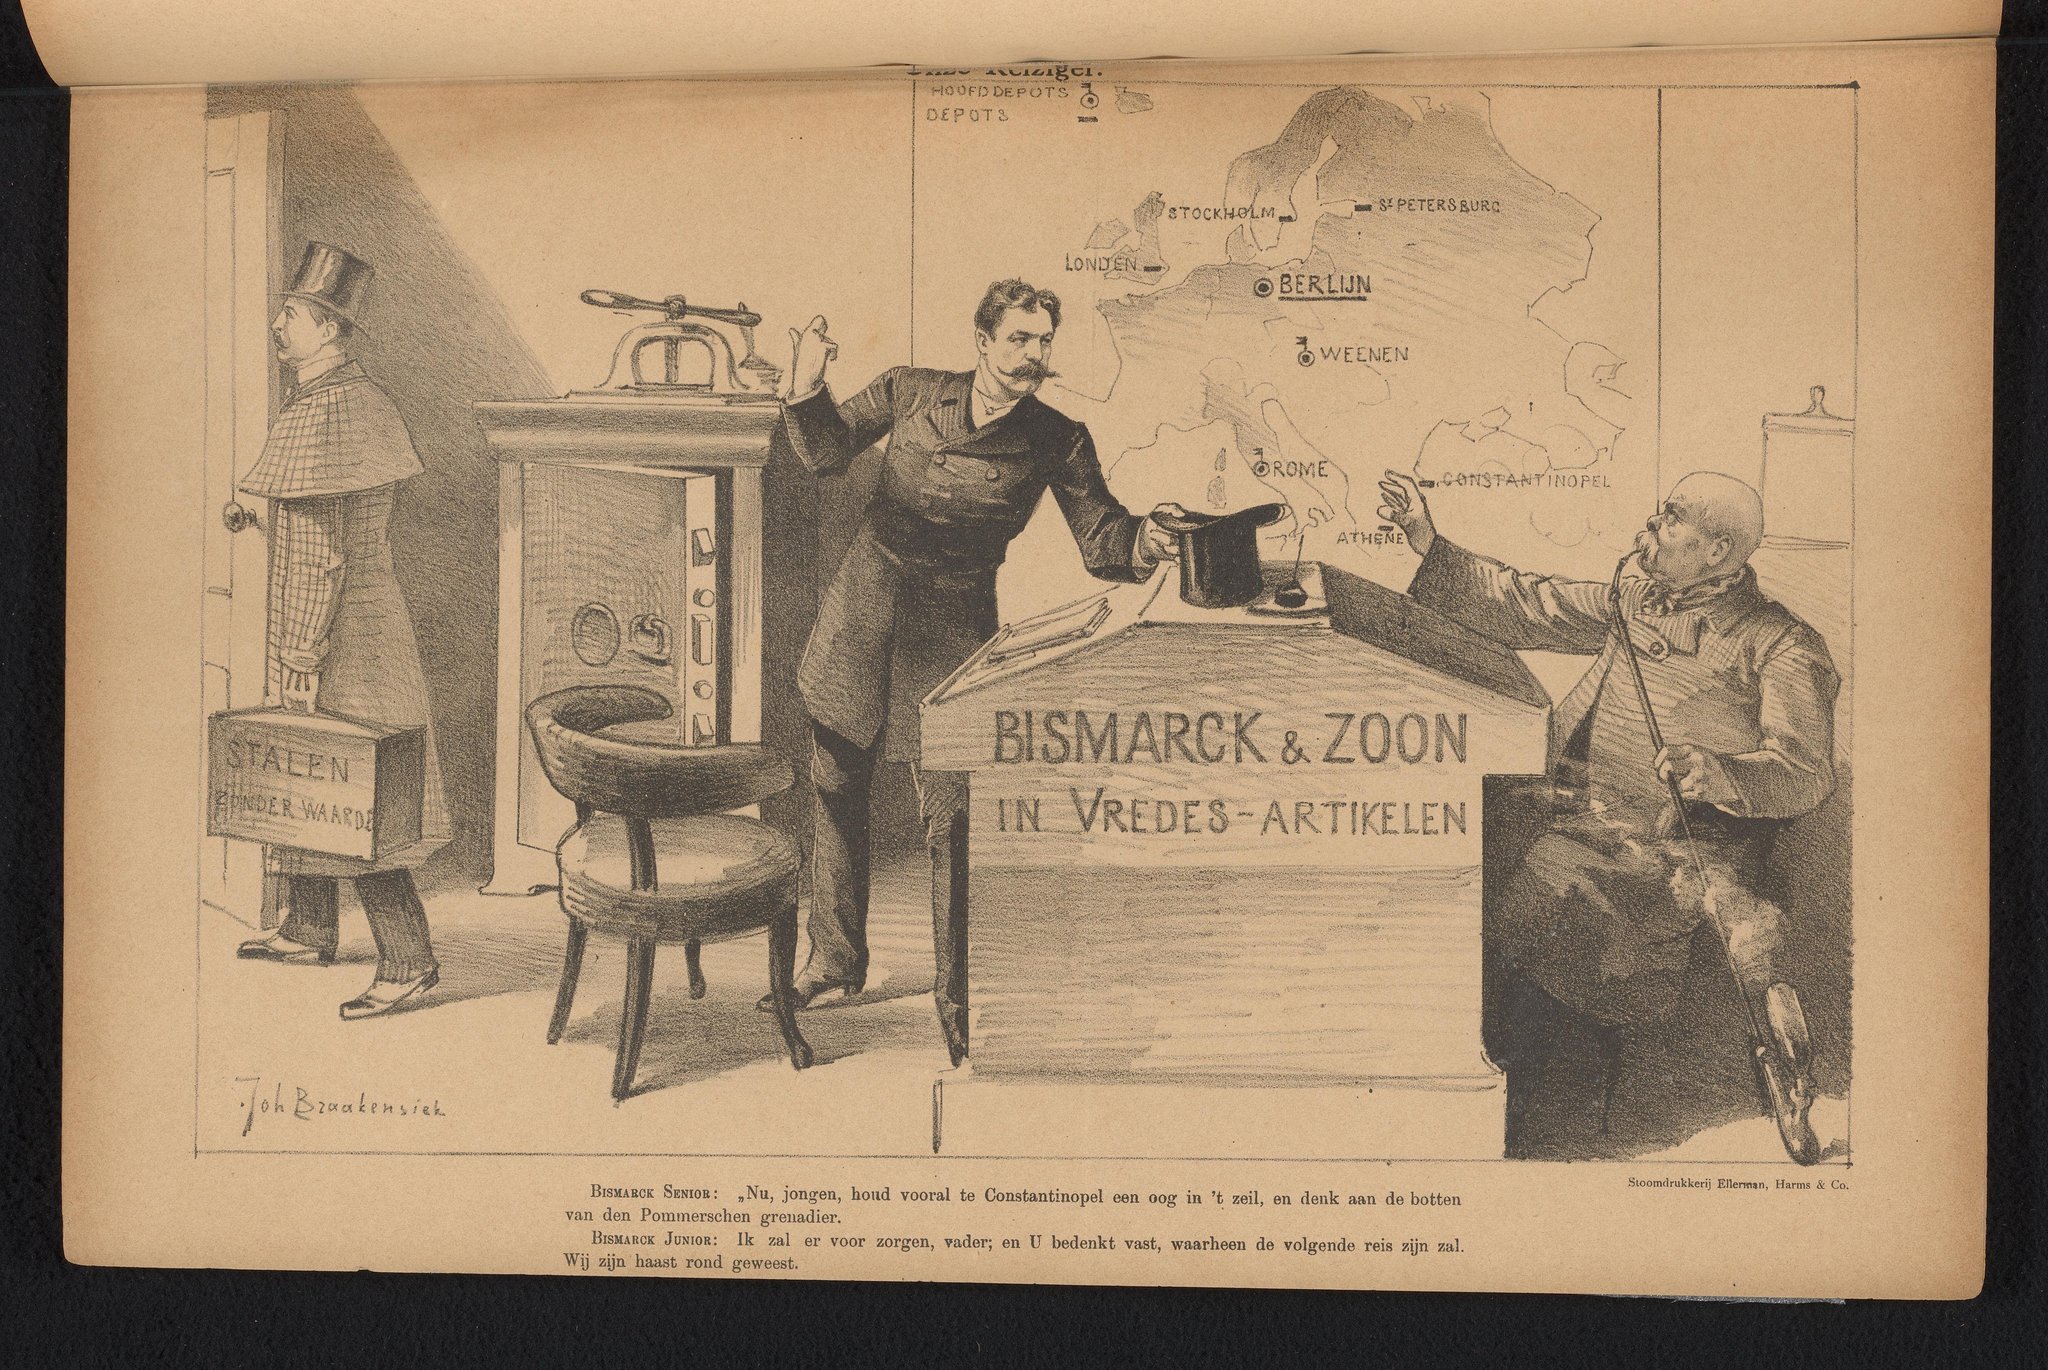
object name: cartoon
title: Onze Reiziger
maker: johan braakensiek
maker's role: draughtsman, print maker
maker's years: 1858-1940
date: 1889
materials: paper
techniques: lithograph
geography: netherlands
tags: wilhelm ii (keizer van duitsland), waving farewell ~ departure on a journey, peace, political caricatures and satires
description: Rijkskanselier Otto von Bismarck wenst zijn zoon, de buitenlandse gezant, Herbert von Bismarck een goede reis. Zijn reisgenoot bij deze missie om vrede te brengen in Europa, de Duitse keizer Wilhelm II, loopt de deur al uit.